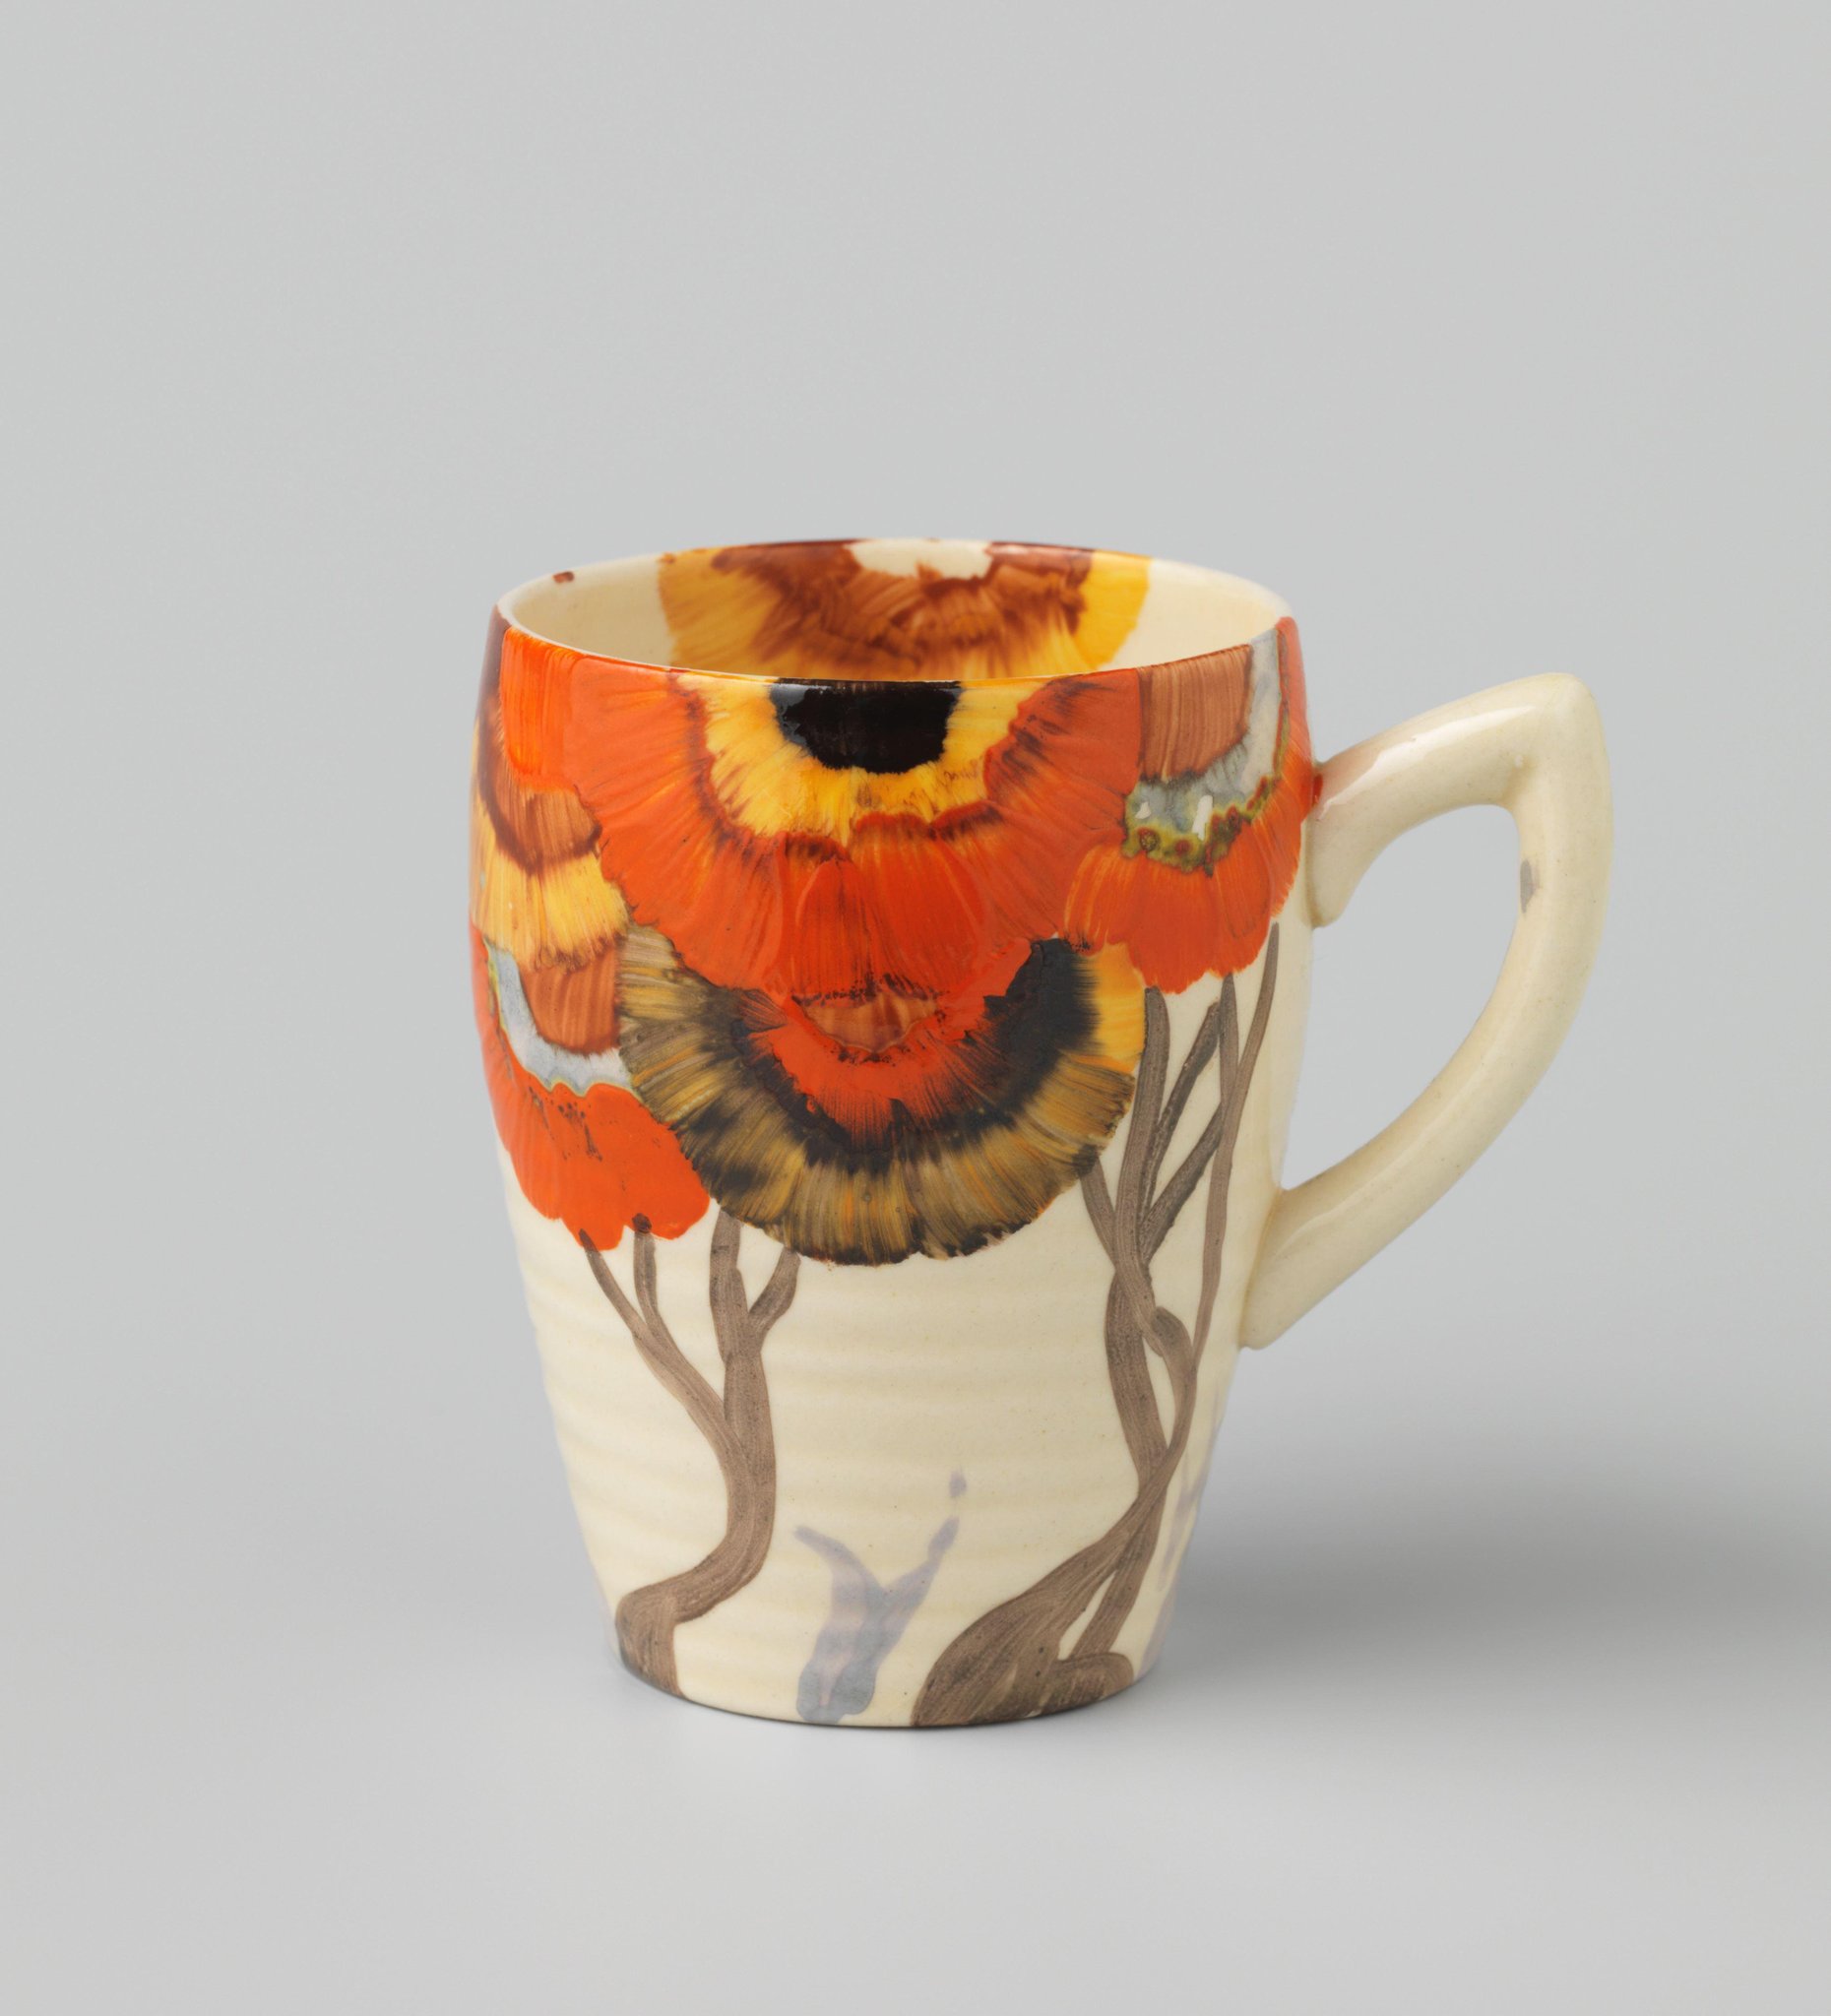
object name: tea cup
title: Theekop met veelkleurig bloemendecor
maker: clarice cliff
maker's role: ceramicist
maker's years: 1899-1972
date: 1930-1940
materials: earthenware, chemical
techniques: painted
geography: england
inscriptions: mark: ‘HAND PAINTED, BIZARRE by CLARICE CLIFF, WILKINSON Ltd, ENGLAND, gestempeld in zwart’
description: Theekop van aardewerk, veelkleurig beschilderd met bloemendecor. Onderdeel van theeservies.